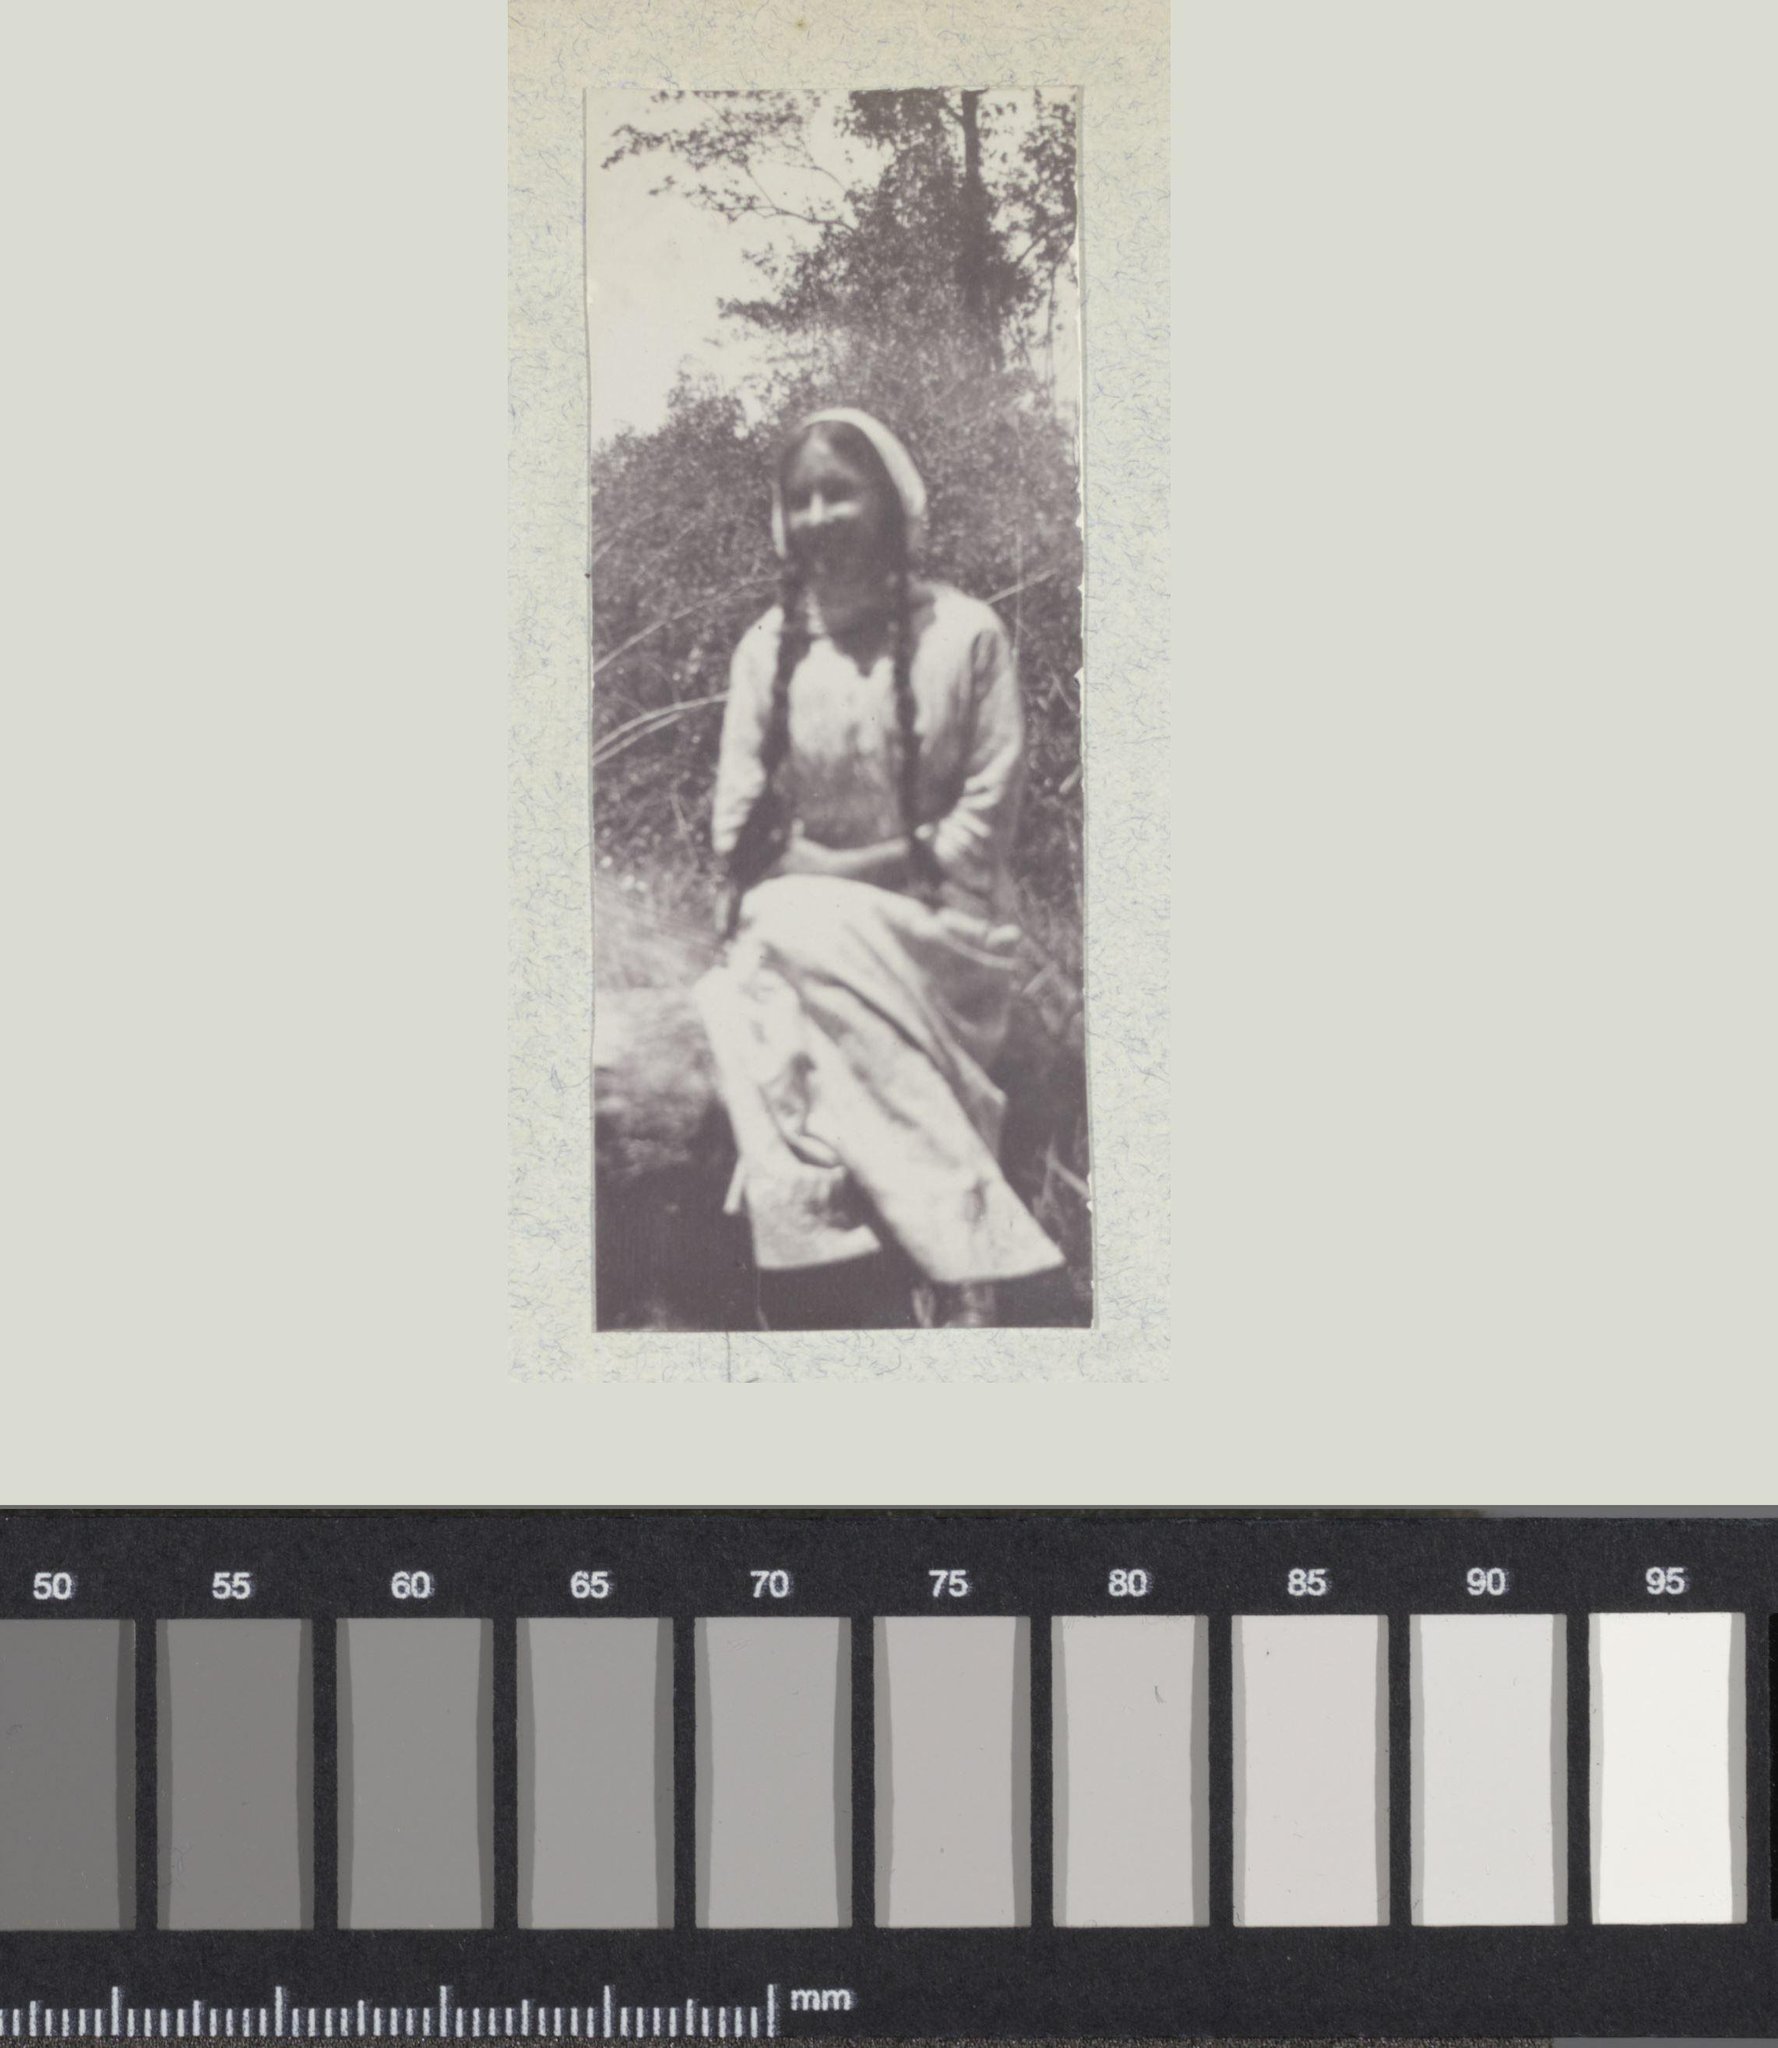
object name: photograph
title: Jonge vrouw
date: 1911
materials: photographic support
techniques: photography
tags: suriname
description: Een jonge vrouw met haar in staartjes, 1911. Onderdeel van het fotoalbum van de familie Boom-Gonggrijp in Suriname en Curaçao.